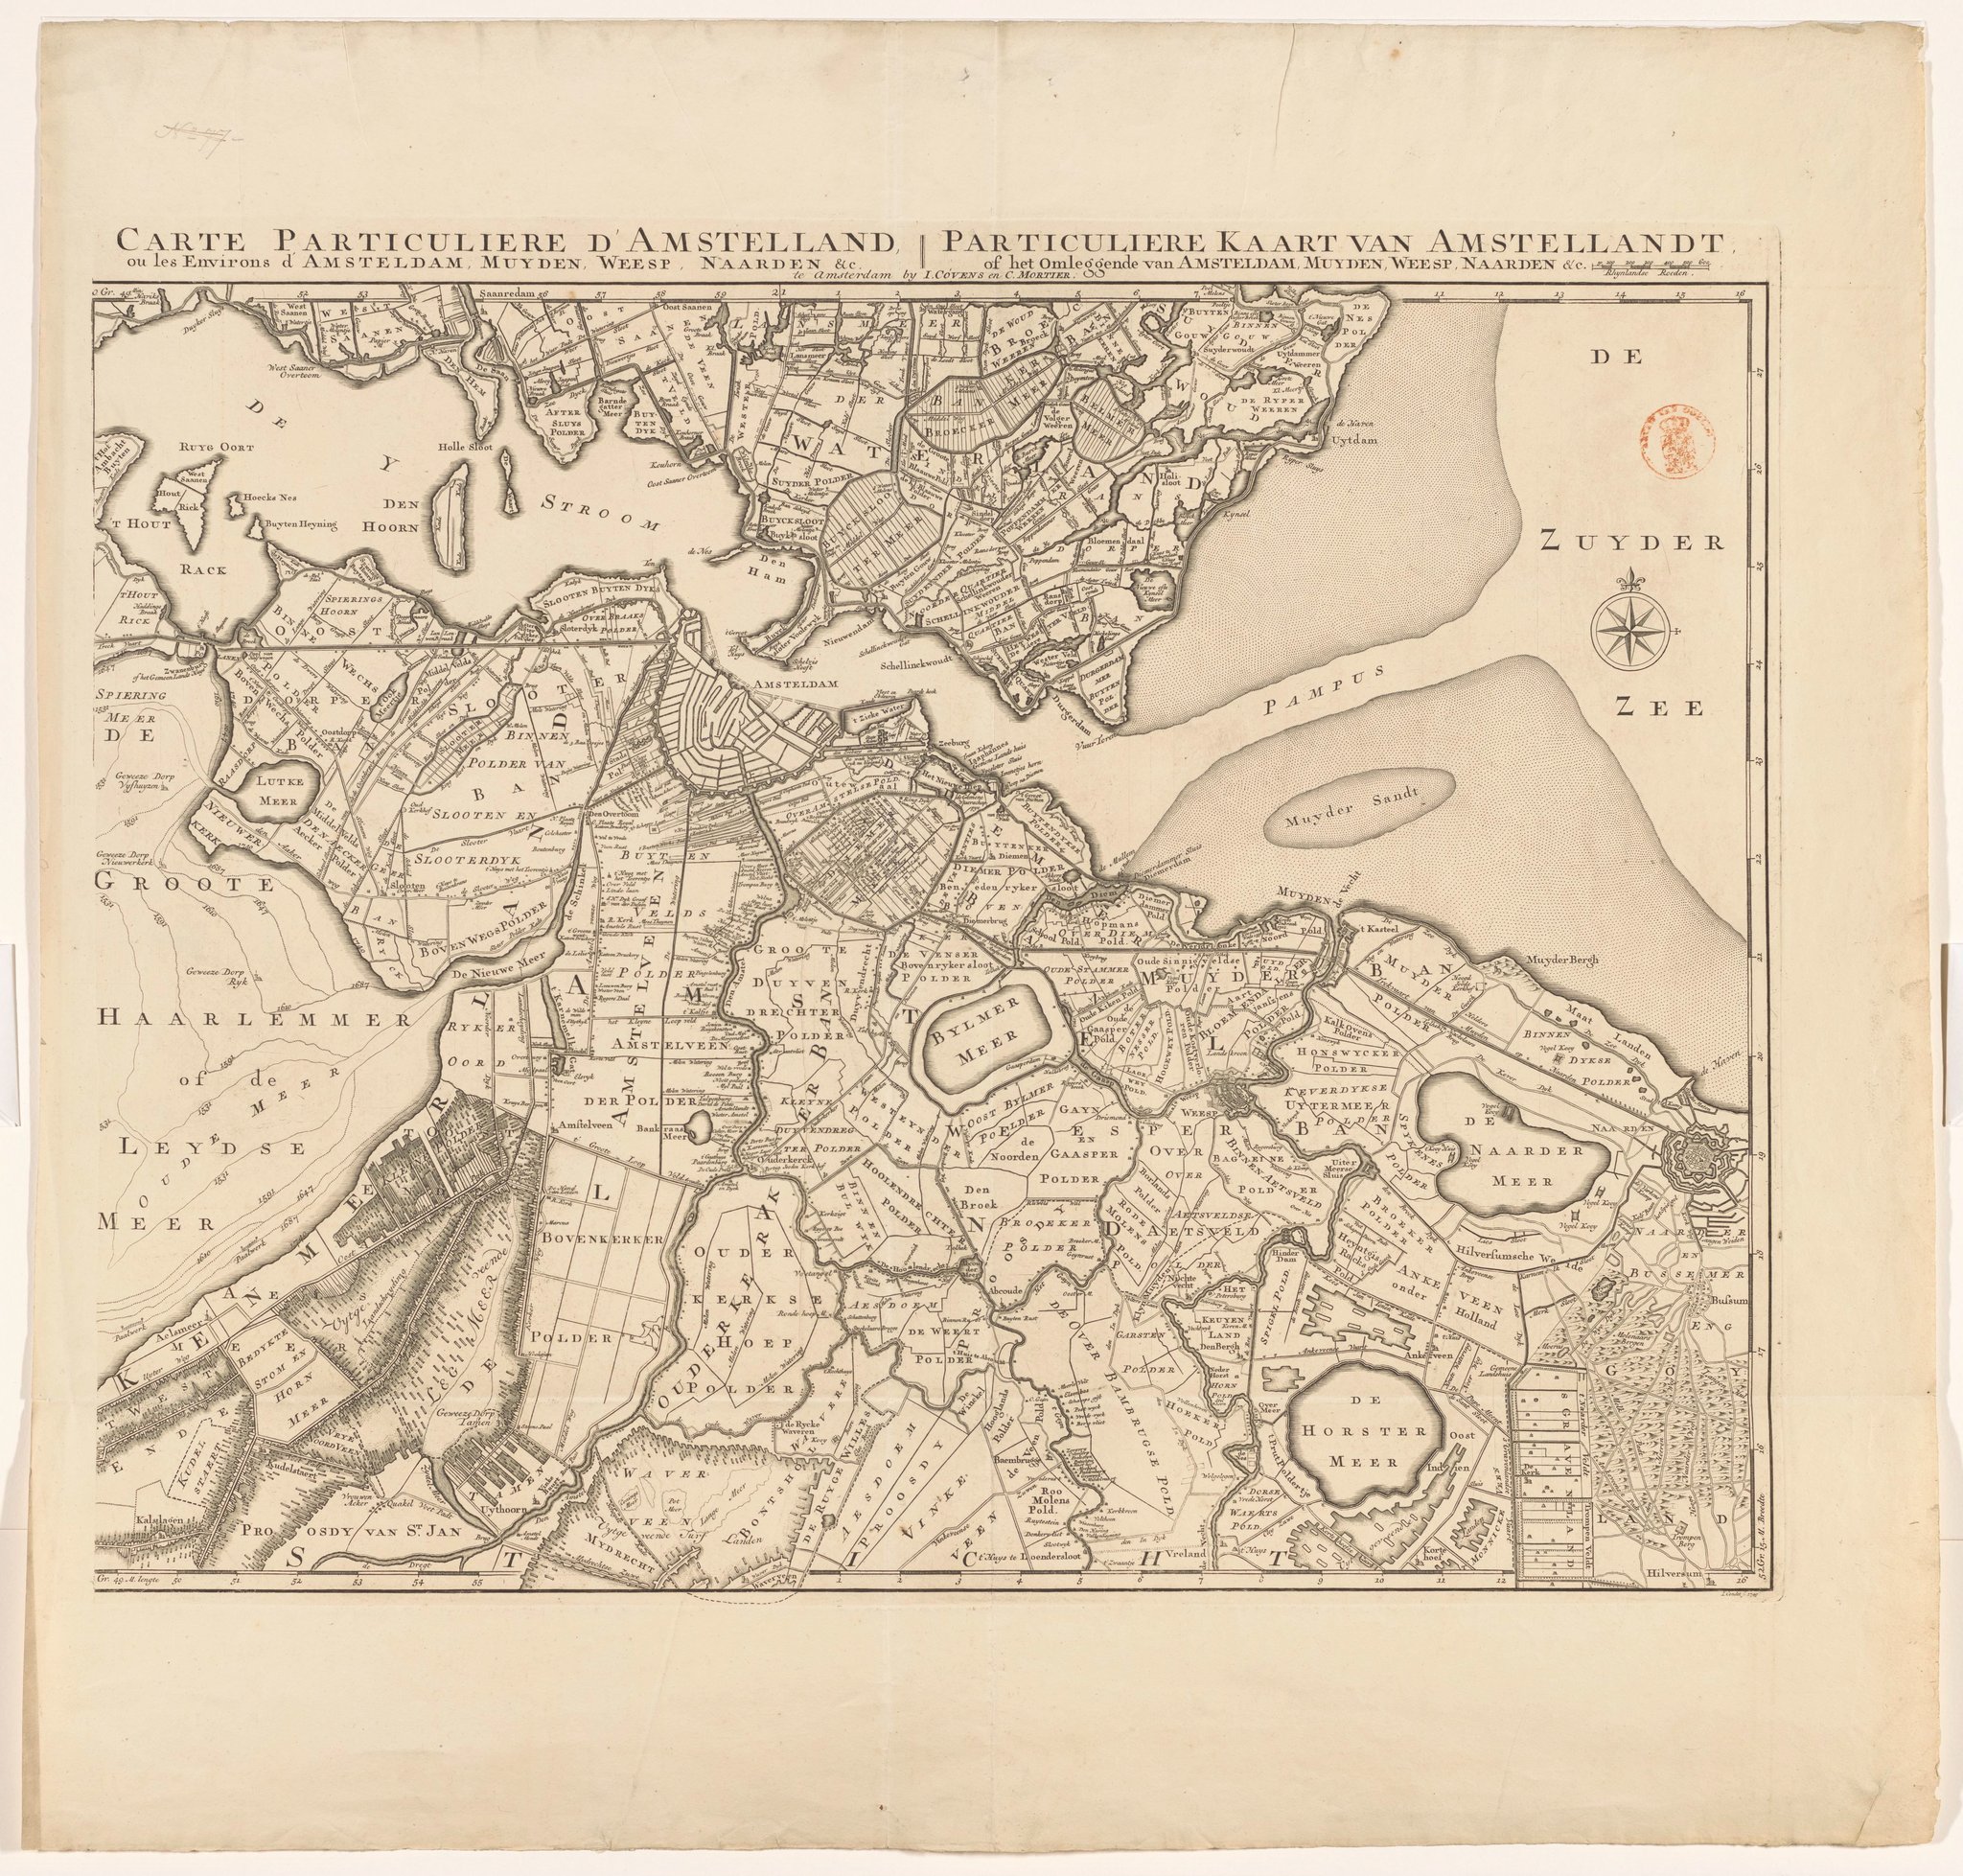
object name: print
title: Particuliere kaart van Amstellandt of het omleggende van Amsterdam, Muyden, Weesp, Naarden &c / Carte particuliere d'Amstelland ou les environs d'Amsterdam, Muyden, Weesp, Naarden &c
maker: johannes condet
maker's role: print maker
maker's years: 1711-1781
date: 1749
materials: paper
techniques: engraving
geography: amsterdam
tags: maps of separate countries or regions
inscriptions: collector's mark: Lugt 19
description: Rechtsboven een schaalstok: Rhynlandse roeden. Gradenverdeling langs de randen. Oriëntatie: noorden rechts.